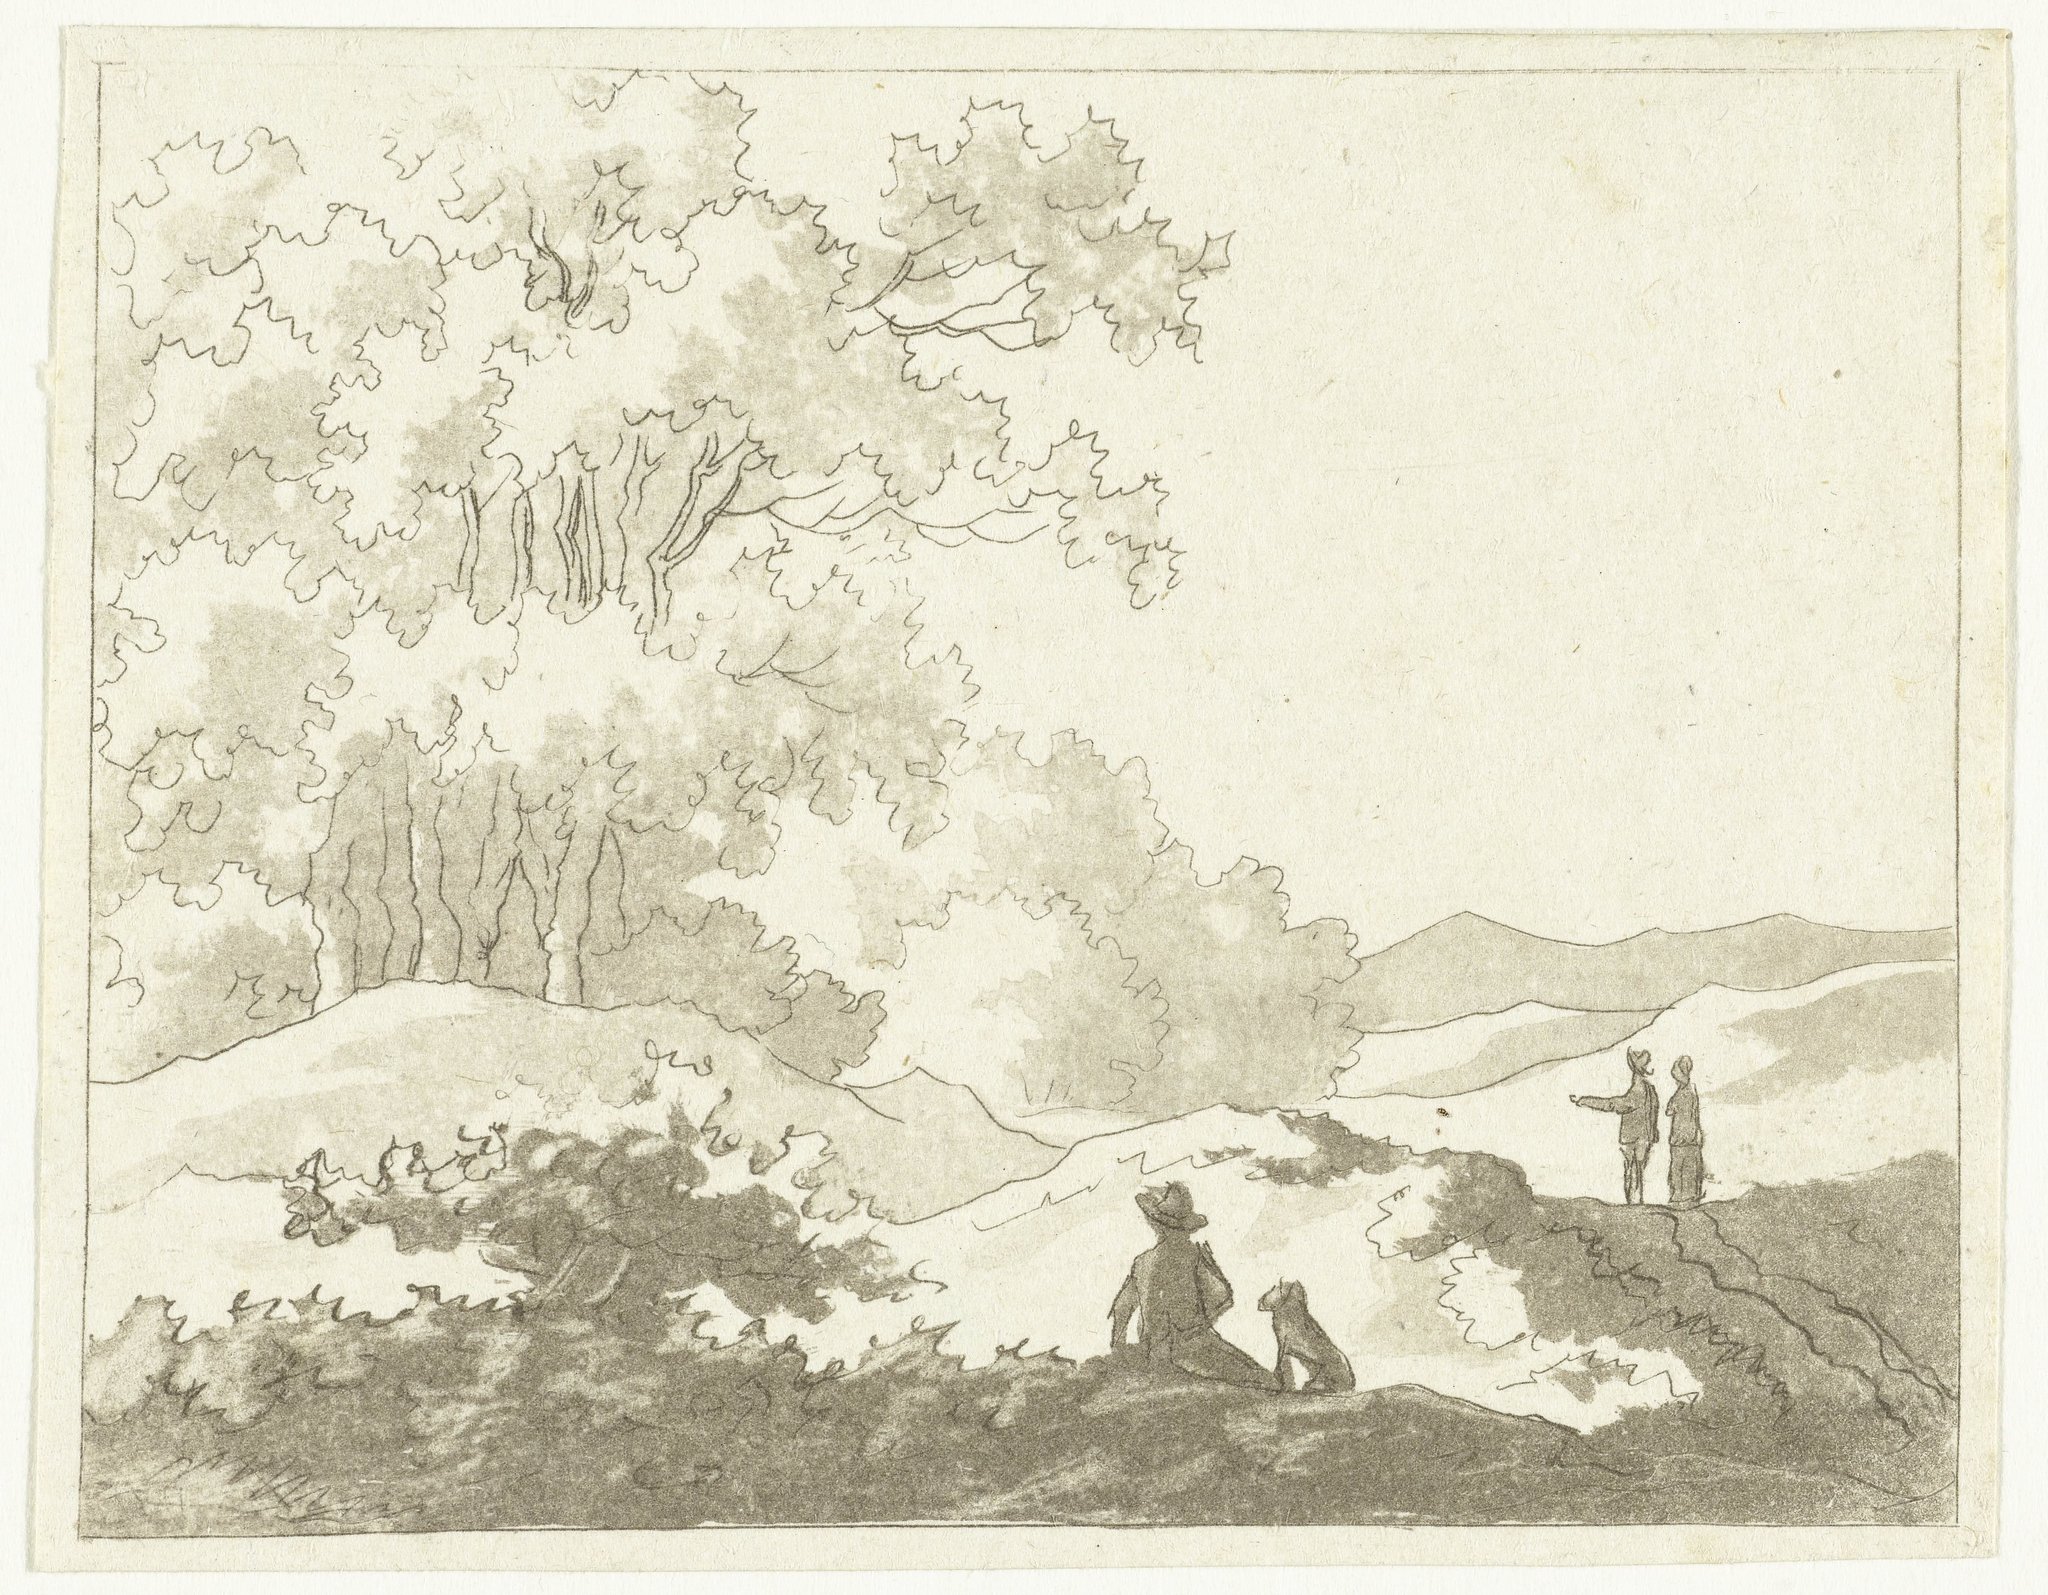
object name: print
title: Duinlandschap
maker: anthonie van den bos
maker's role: draughtsman, print maker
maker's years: 1763-1838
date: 1778-1838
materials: paper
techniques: printmaking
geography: netherlands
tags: dunes (sea not visible); in the dunes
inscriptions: collector's mark: Lugt 2228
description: Twee wandelaars lopen op een pad door de duinen. Een derde wandelaar rust uit. Hij zit met zijn hond op de grond en kijkt naar een groep bomen.